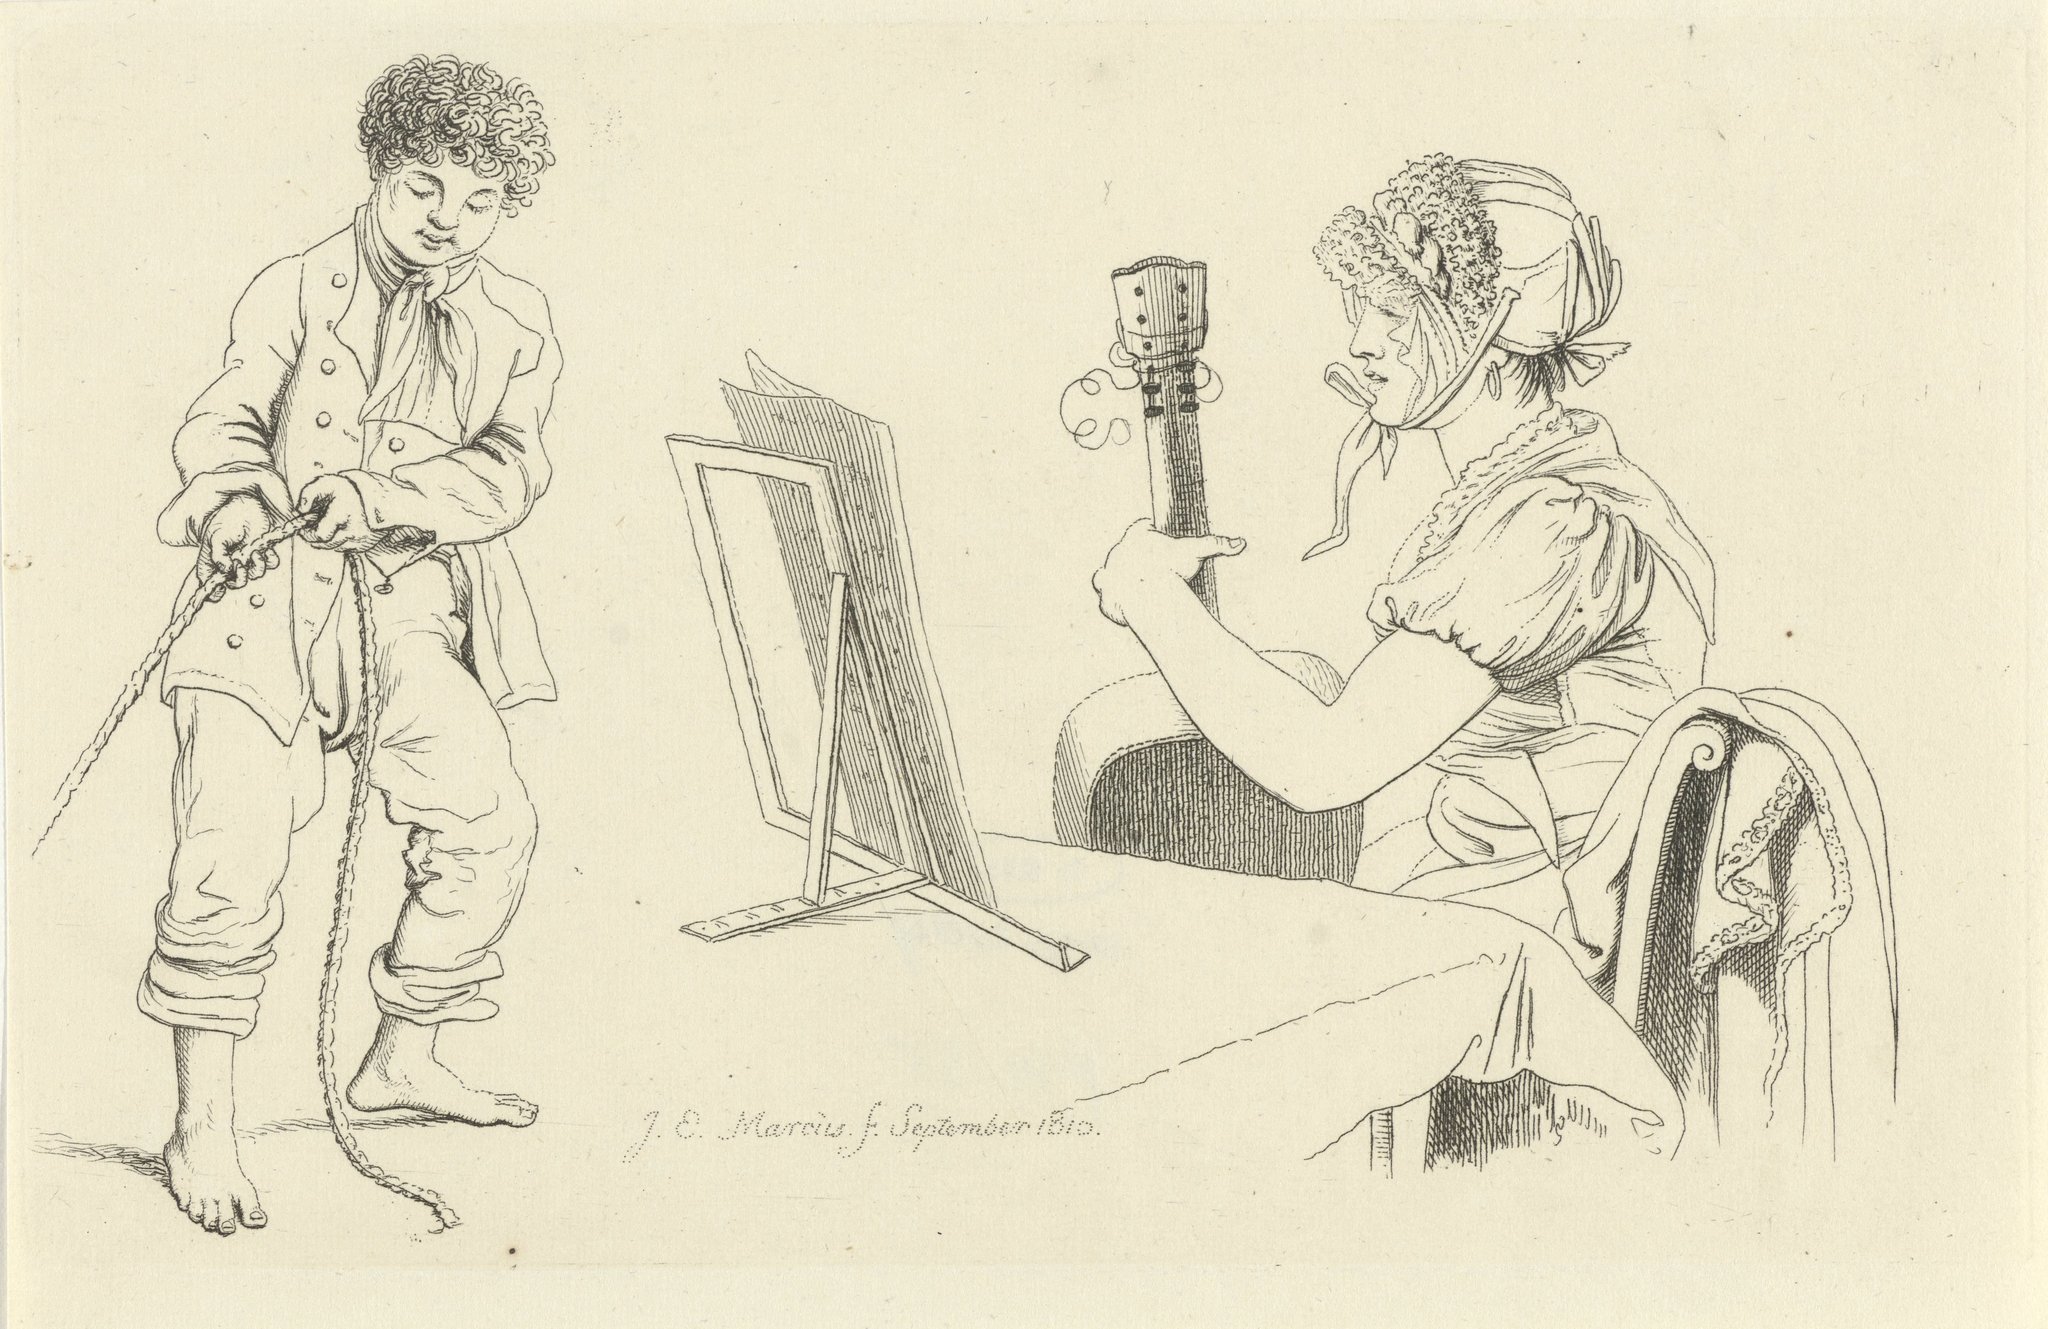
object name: print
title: Studie-prentwerk / Etudes gravées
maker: jacob ernst marcus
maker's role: draughtsman, print maker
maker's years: 1774-1826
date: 1809-1810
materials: paper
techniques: etching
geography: amsterdam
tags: drawing, pulling something, cithern, mandolin, guitar, balalaika (+ artist at work), tools, aids, implements ~ crafts and industries: rope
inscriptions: collector's mark: Lugt 2228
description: Serie voor het eerst uitgegeven door Jacob Ernst Marcus onder de titel Studiebeelden en Fragmenten. Amsterdam: ca.1816. Later heruitgegeven als: Studie-prentwerk/ Etudes gravées.